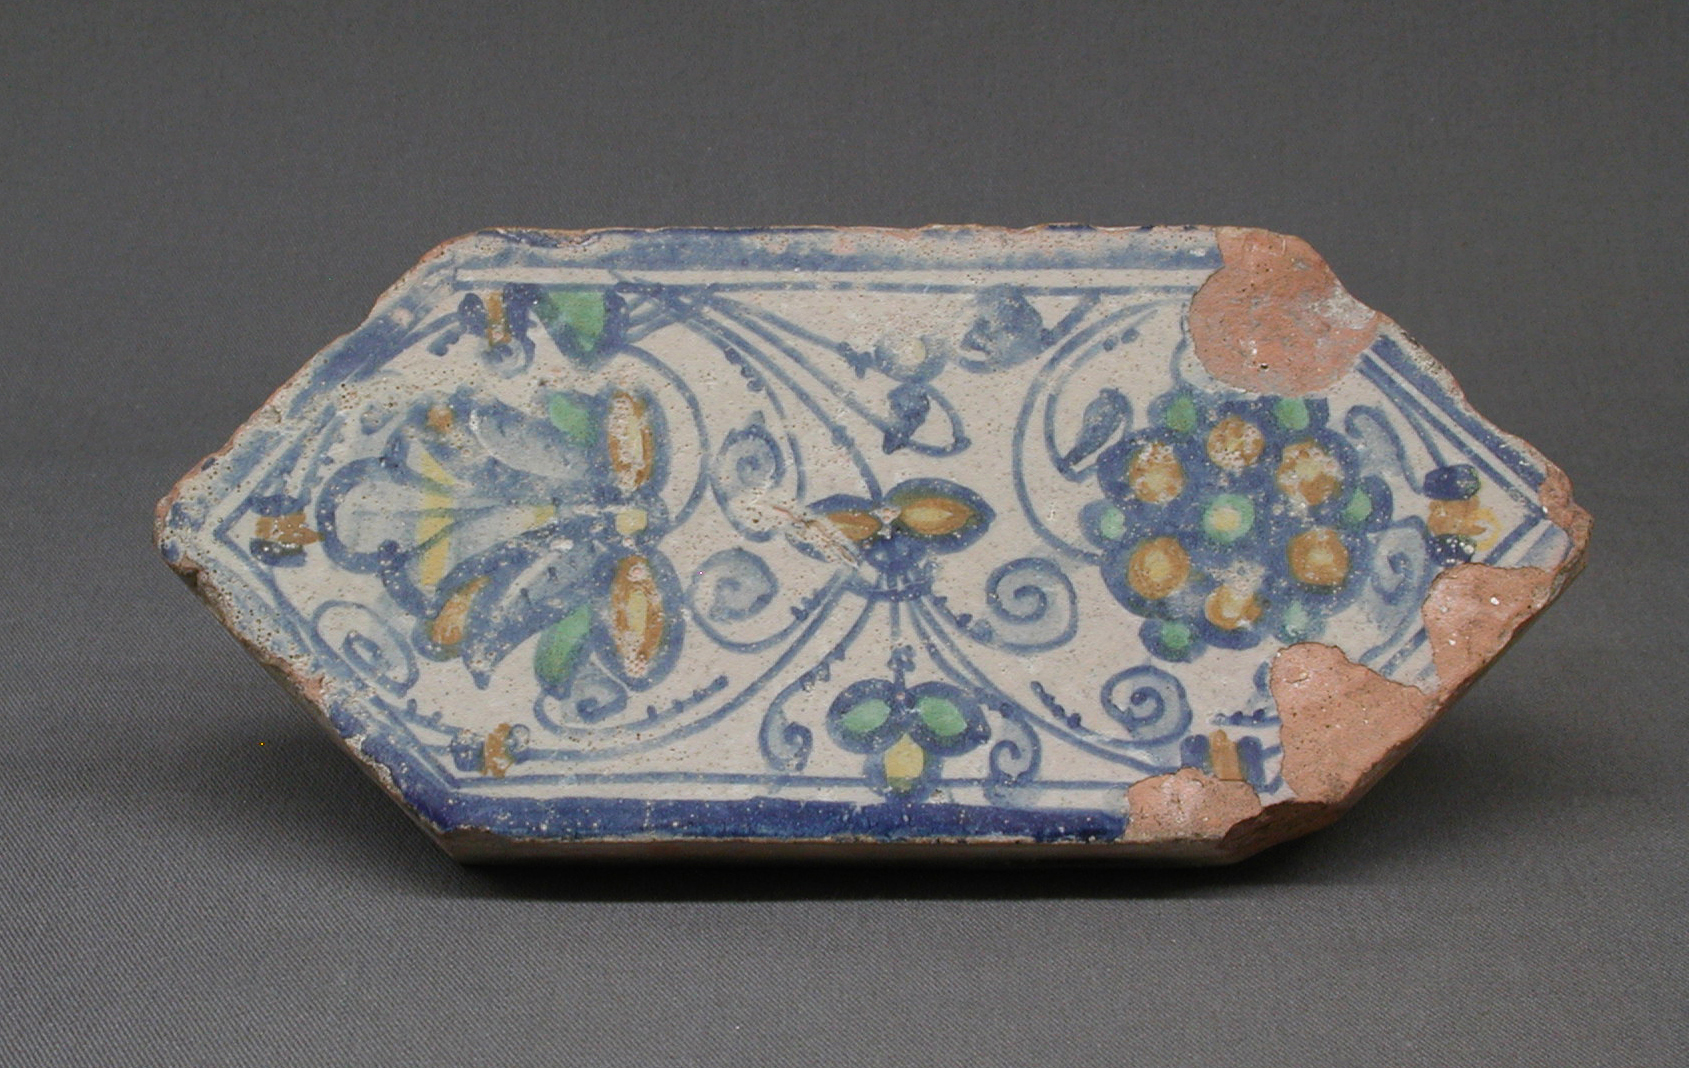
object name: tile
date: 1451-1500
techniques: maiolica, glazing